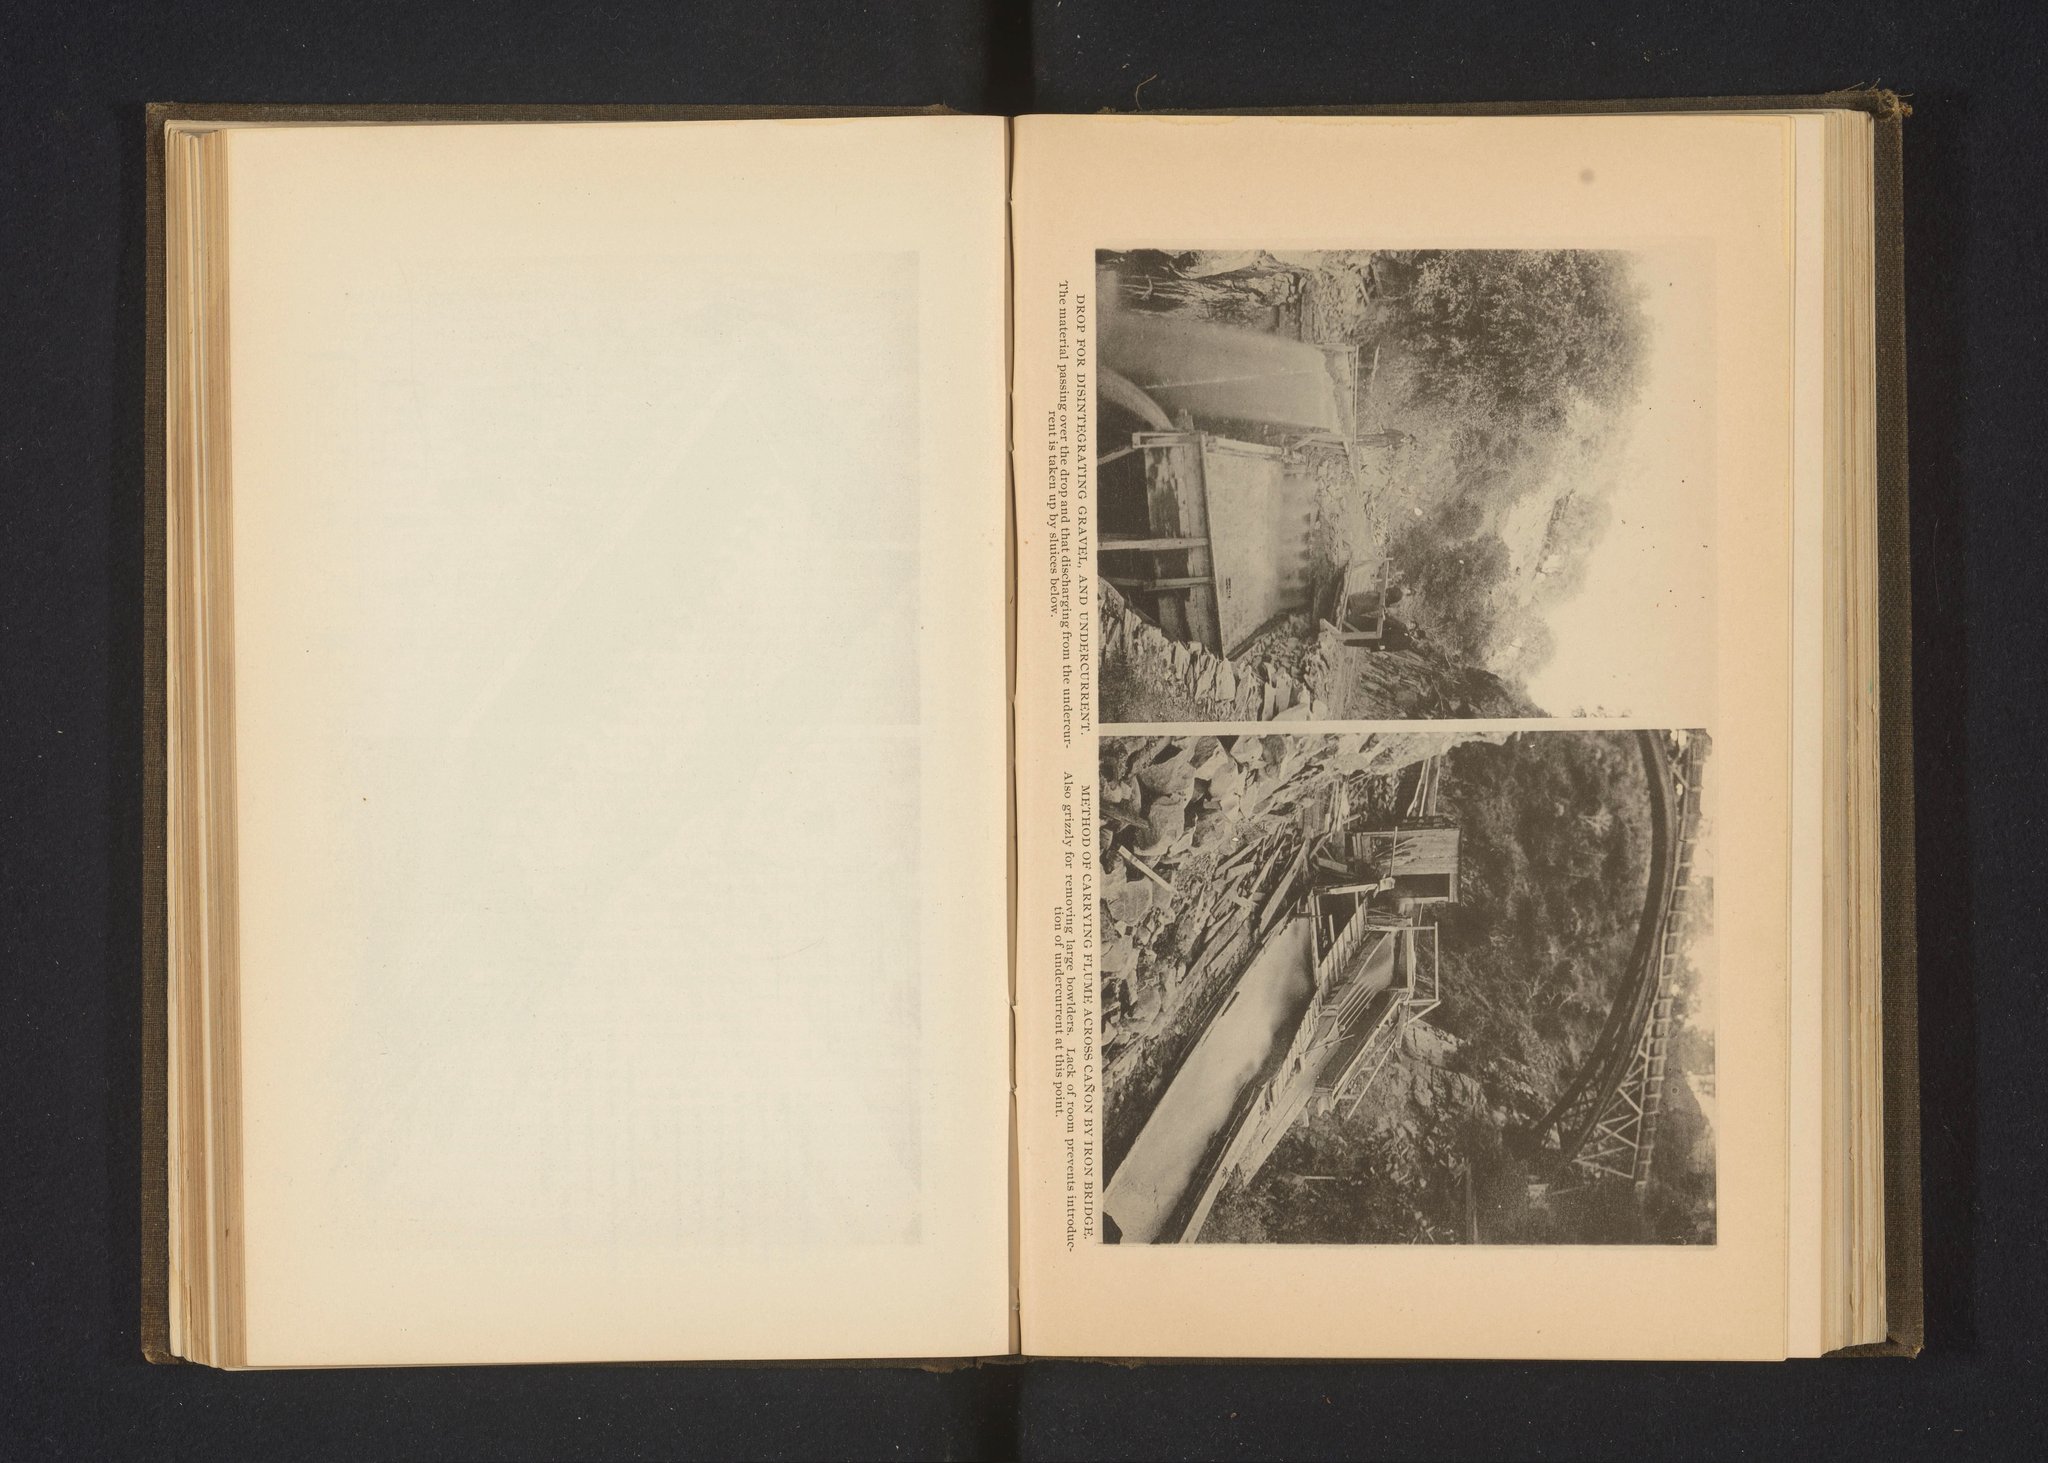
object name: page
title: Gezicht op een opvangplaats voor grind in een mijn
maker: Anonymous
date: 1885-1890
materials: paper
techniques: photograph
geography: california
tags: mine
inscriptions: inscription: ‘The material passing over the drop and that discharging from the undercur-/ rent is taken up by sluices below.’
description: Prent op tweede ongenummerde pagina na pagina 130.